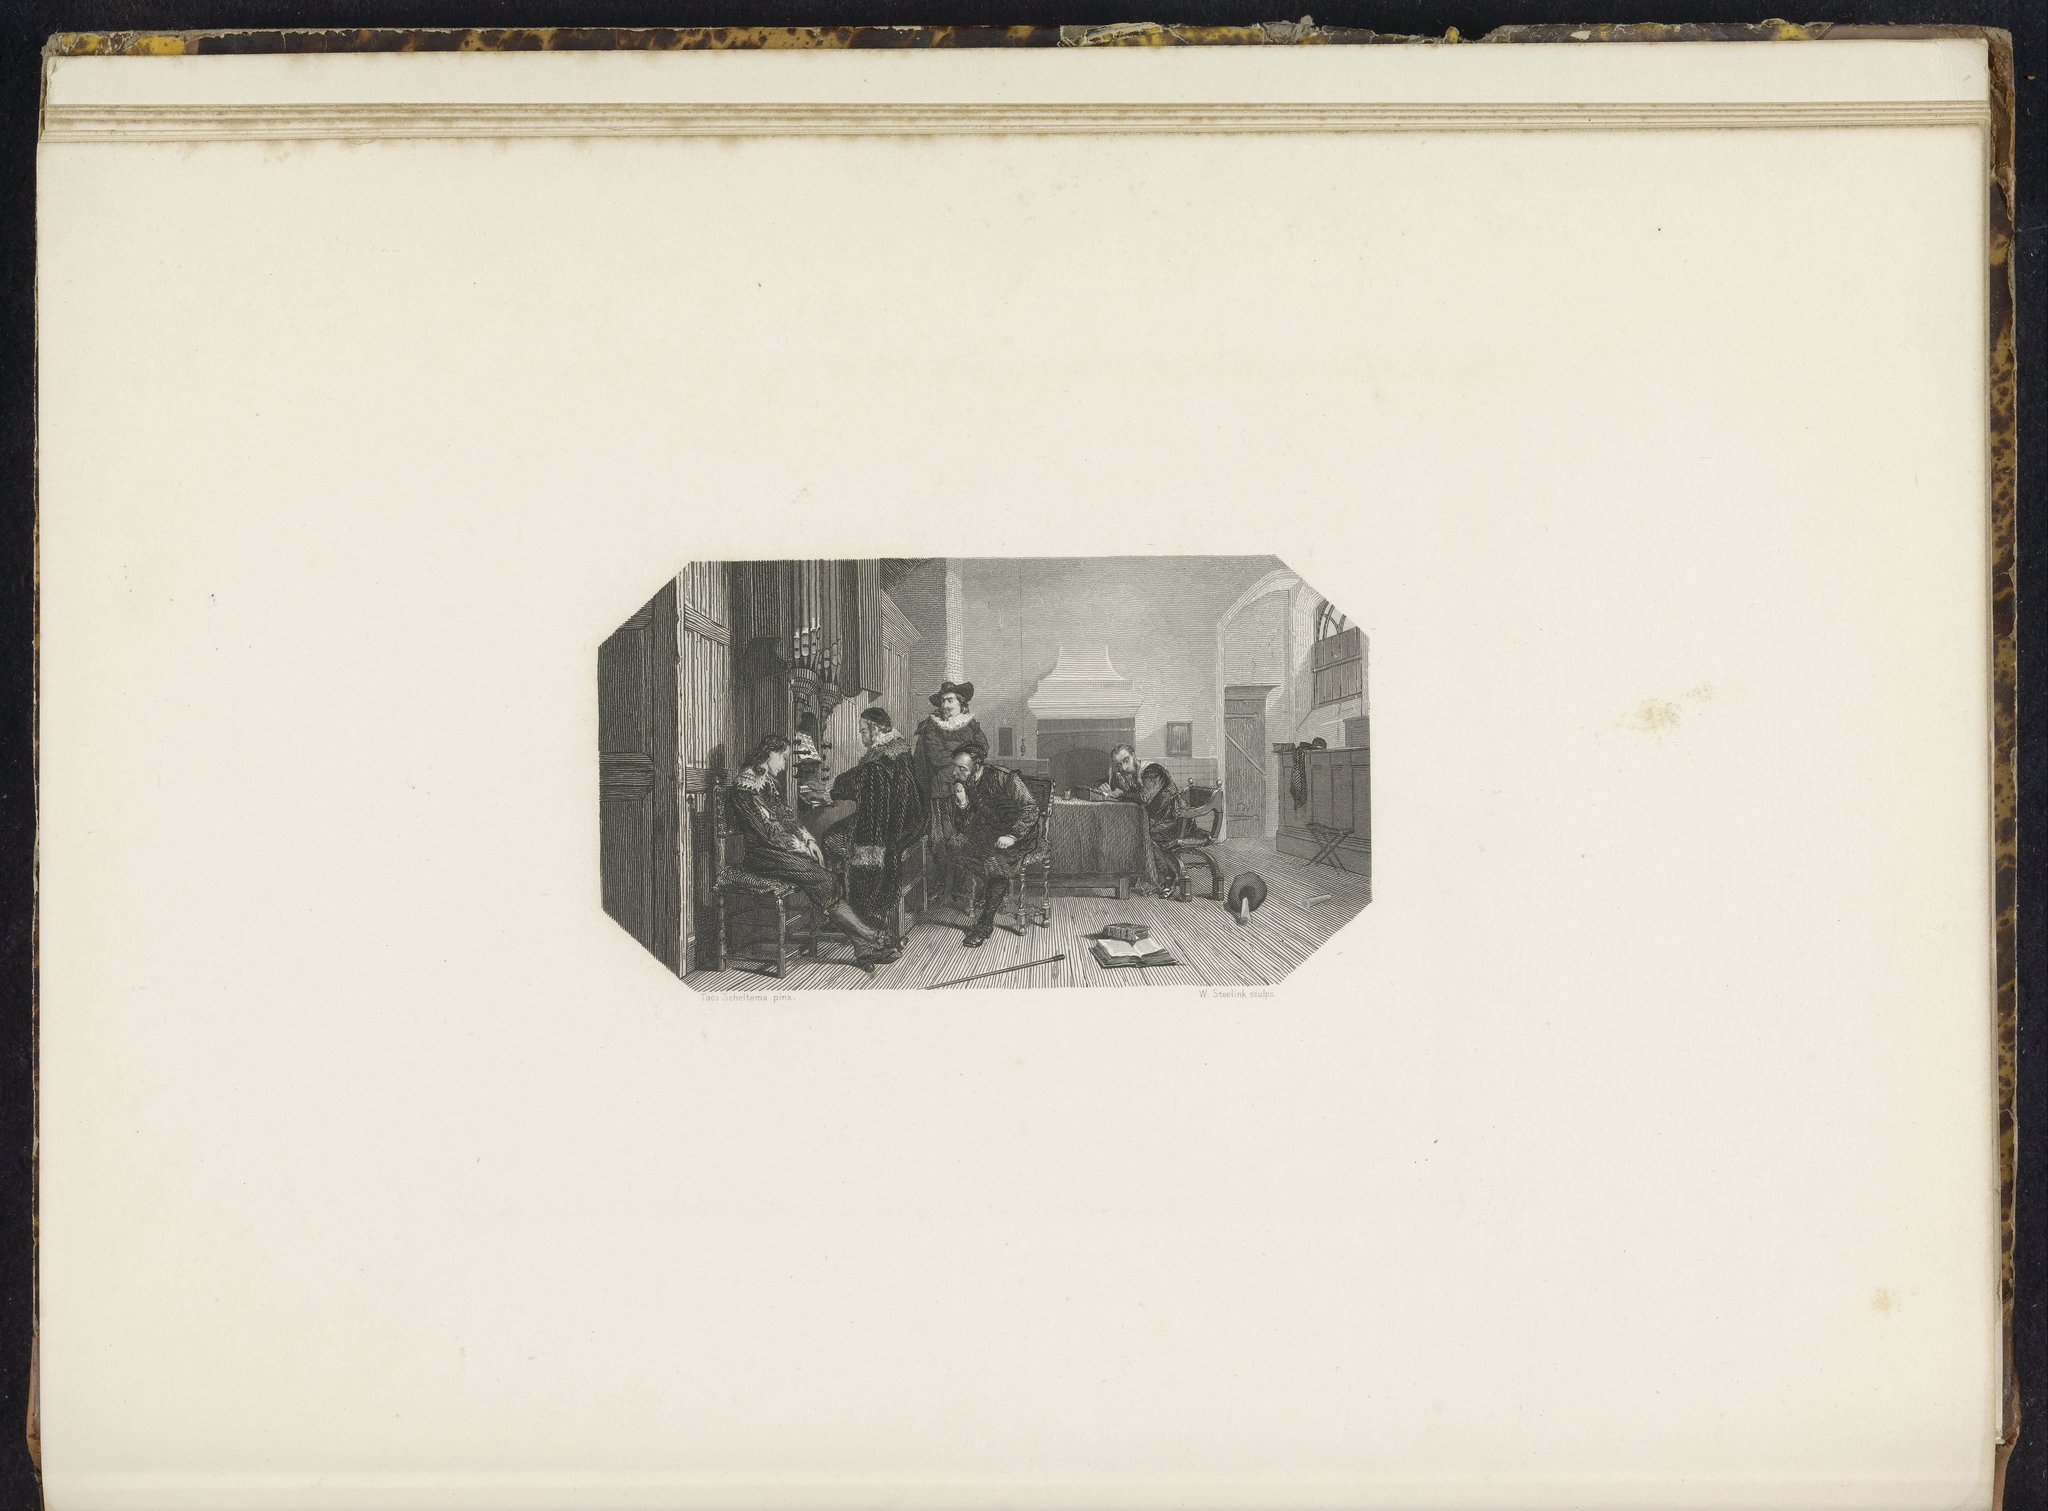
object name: history print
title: Jan Pieters Sweelinck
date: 1865-1870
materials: paper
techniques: engraving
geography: netherlands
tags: deventer, amsterdam, church organ, interior of church, composer at work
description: De componist Jan Pieterszoon Sweelinck componeert voor de orgel, ca. 1600. Onderdeel van de groep staalgravures naar de schilderijen van de Historische Galerij der Maatschappij Arti et Amicitiae.